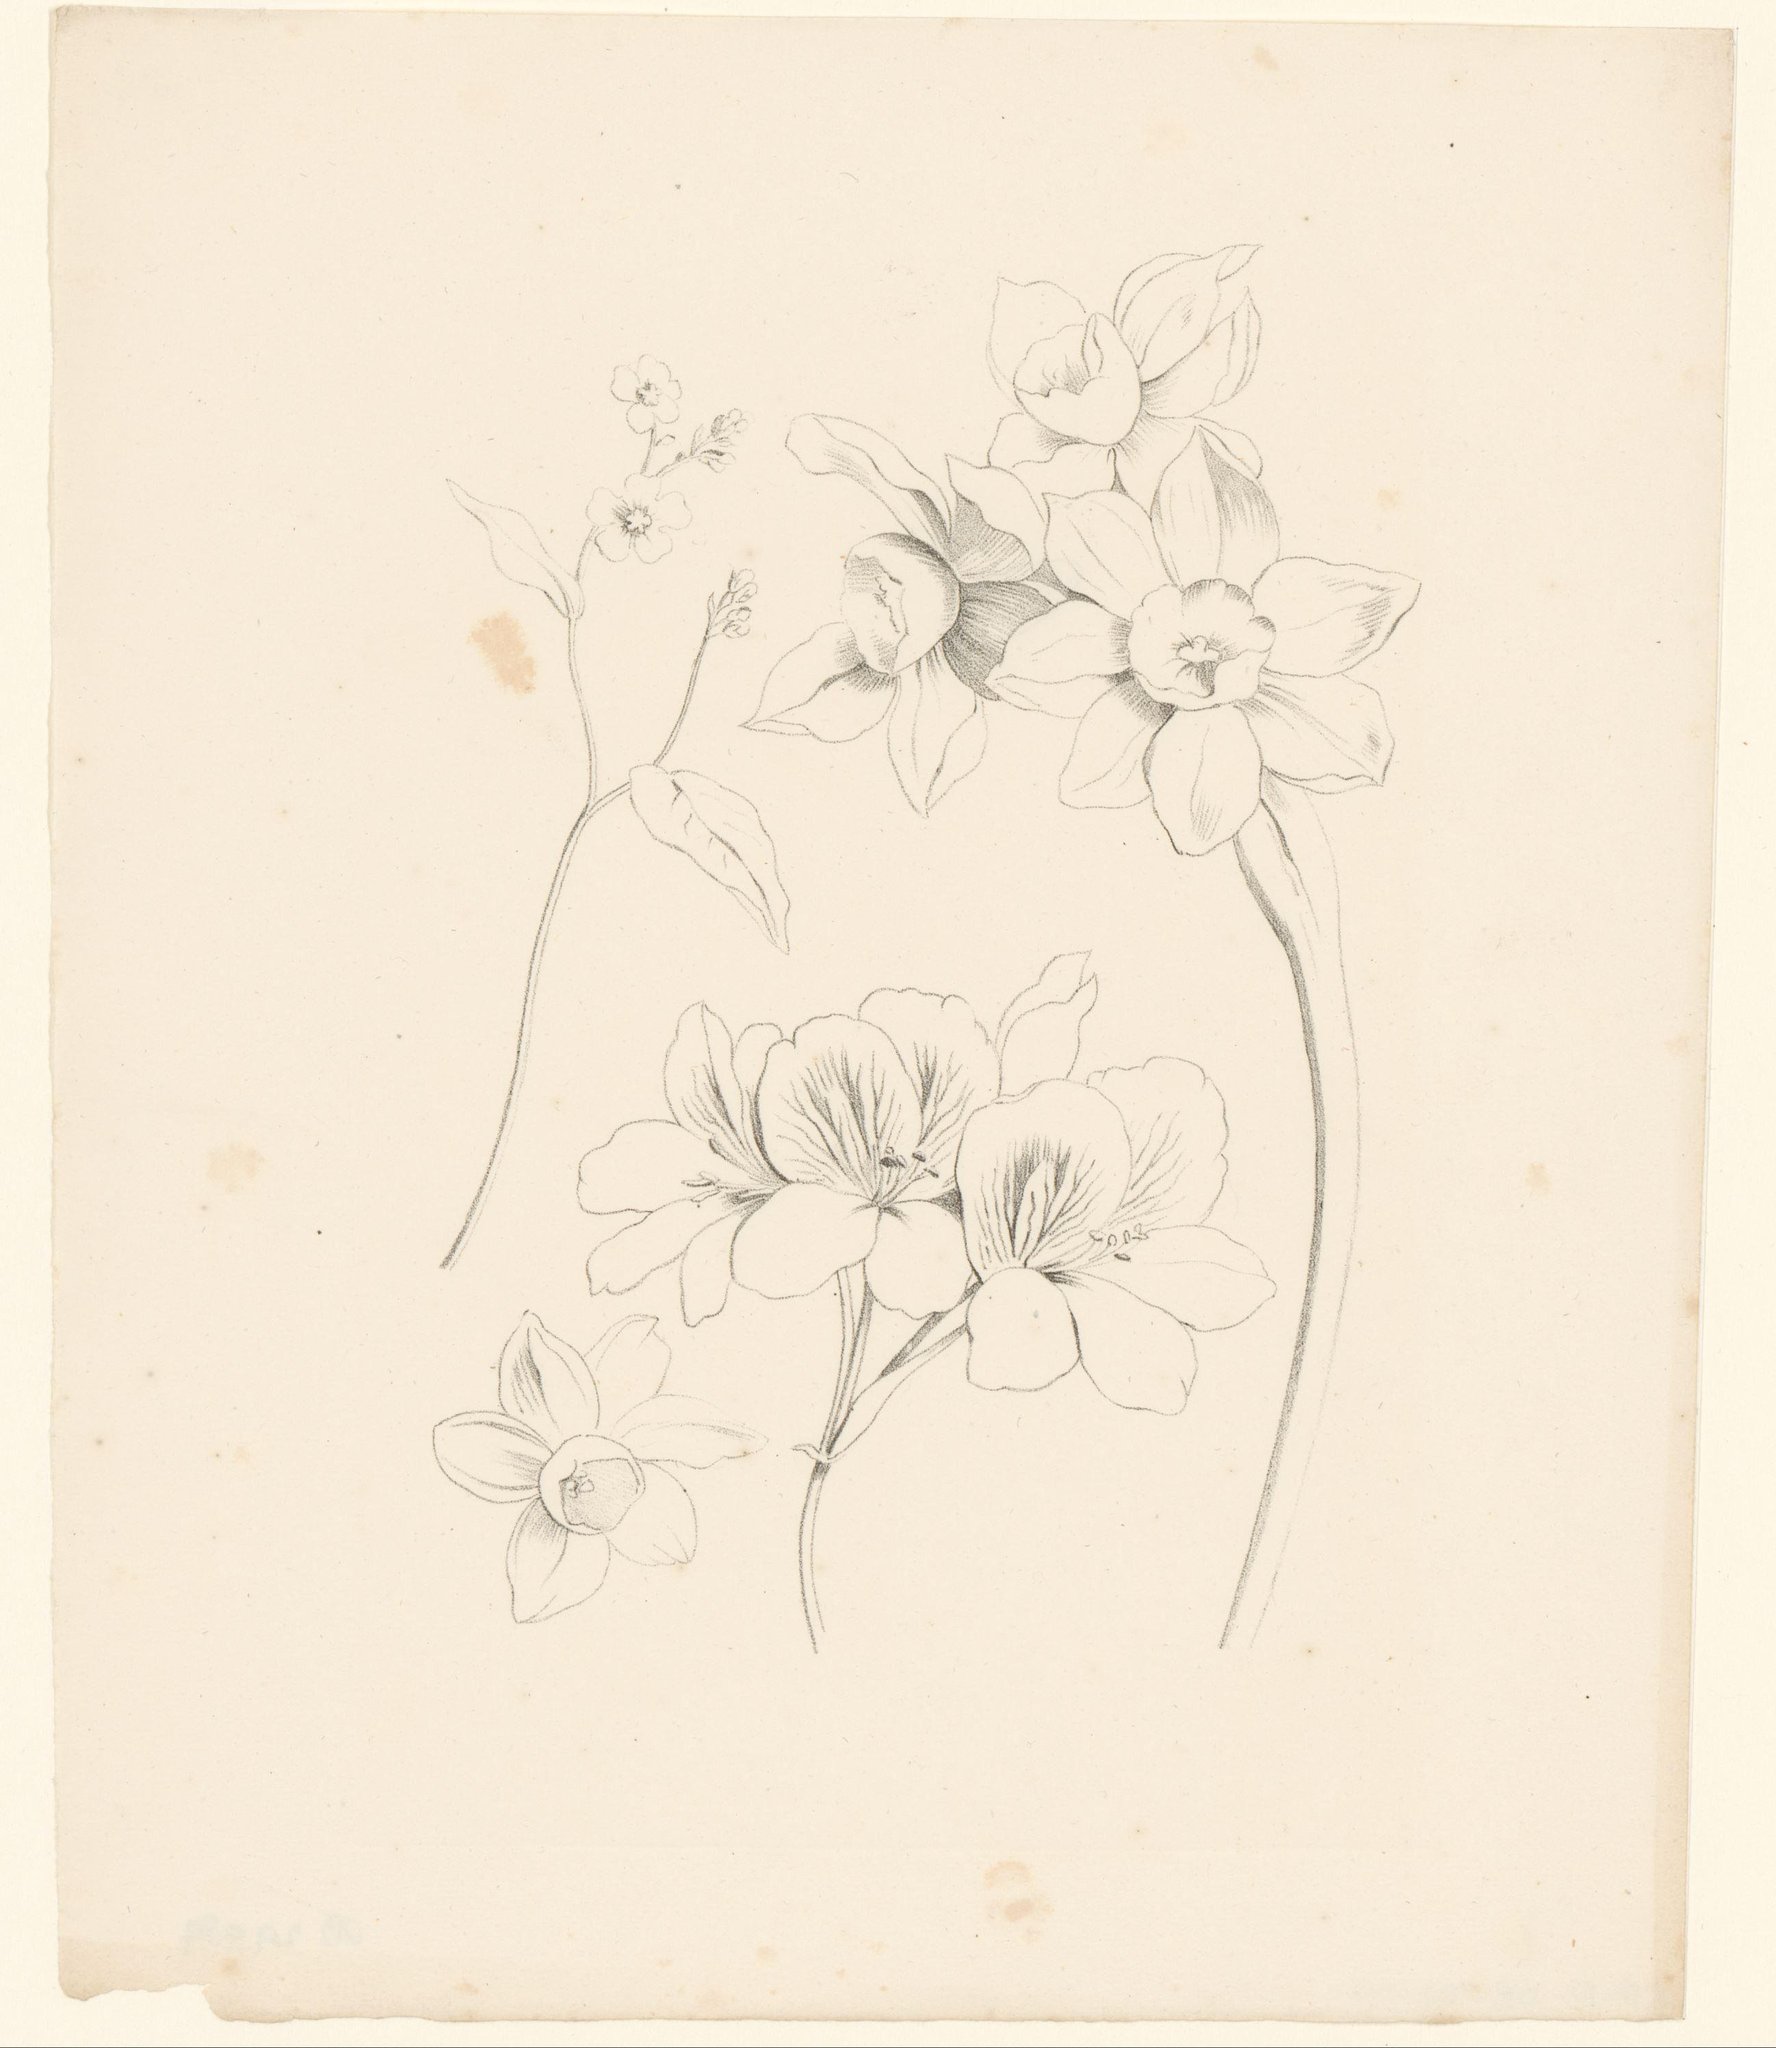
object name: print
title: Narcissen en andere bloemen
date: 1811-1851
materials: paper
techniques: lithograph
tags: flowers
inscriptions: watermark